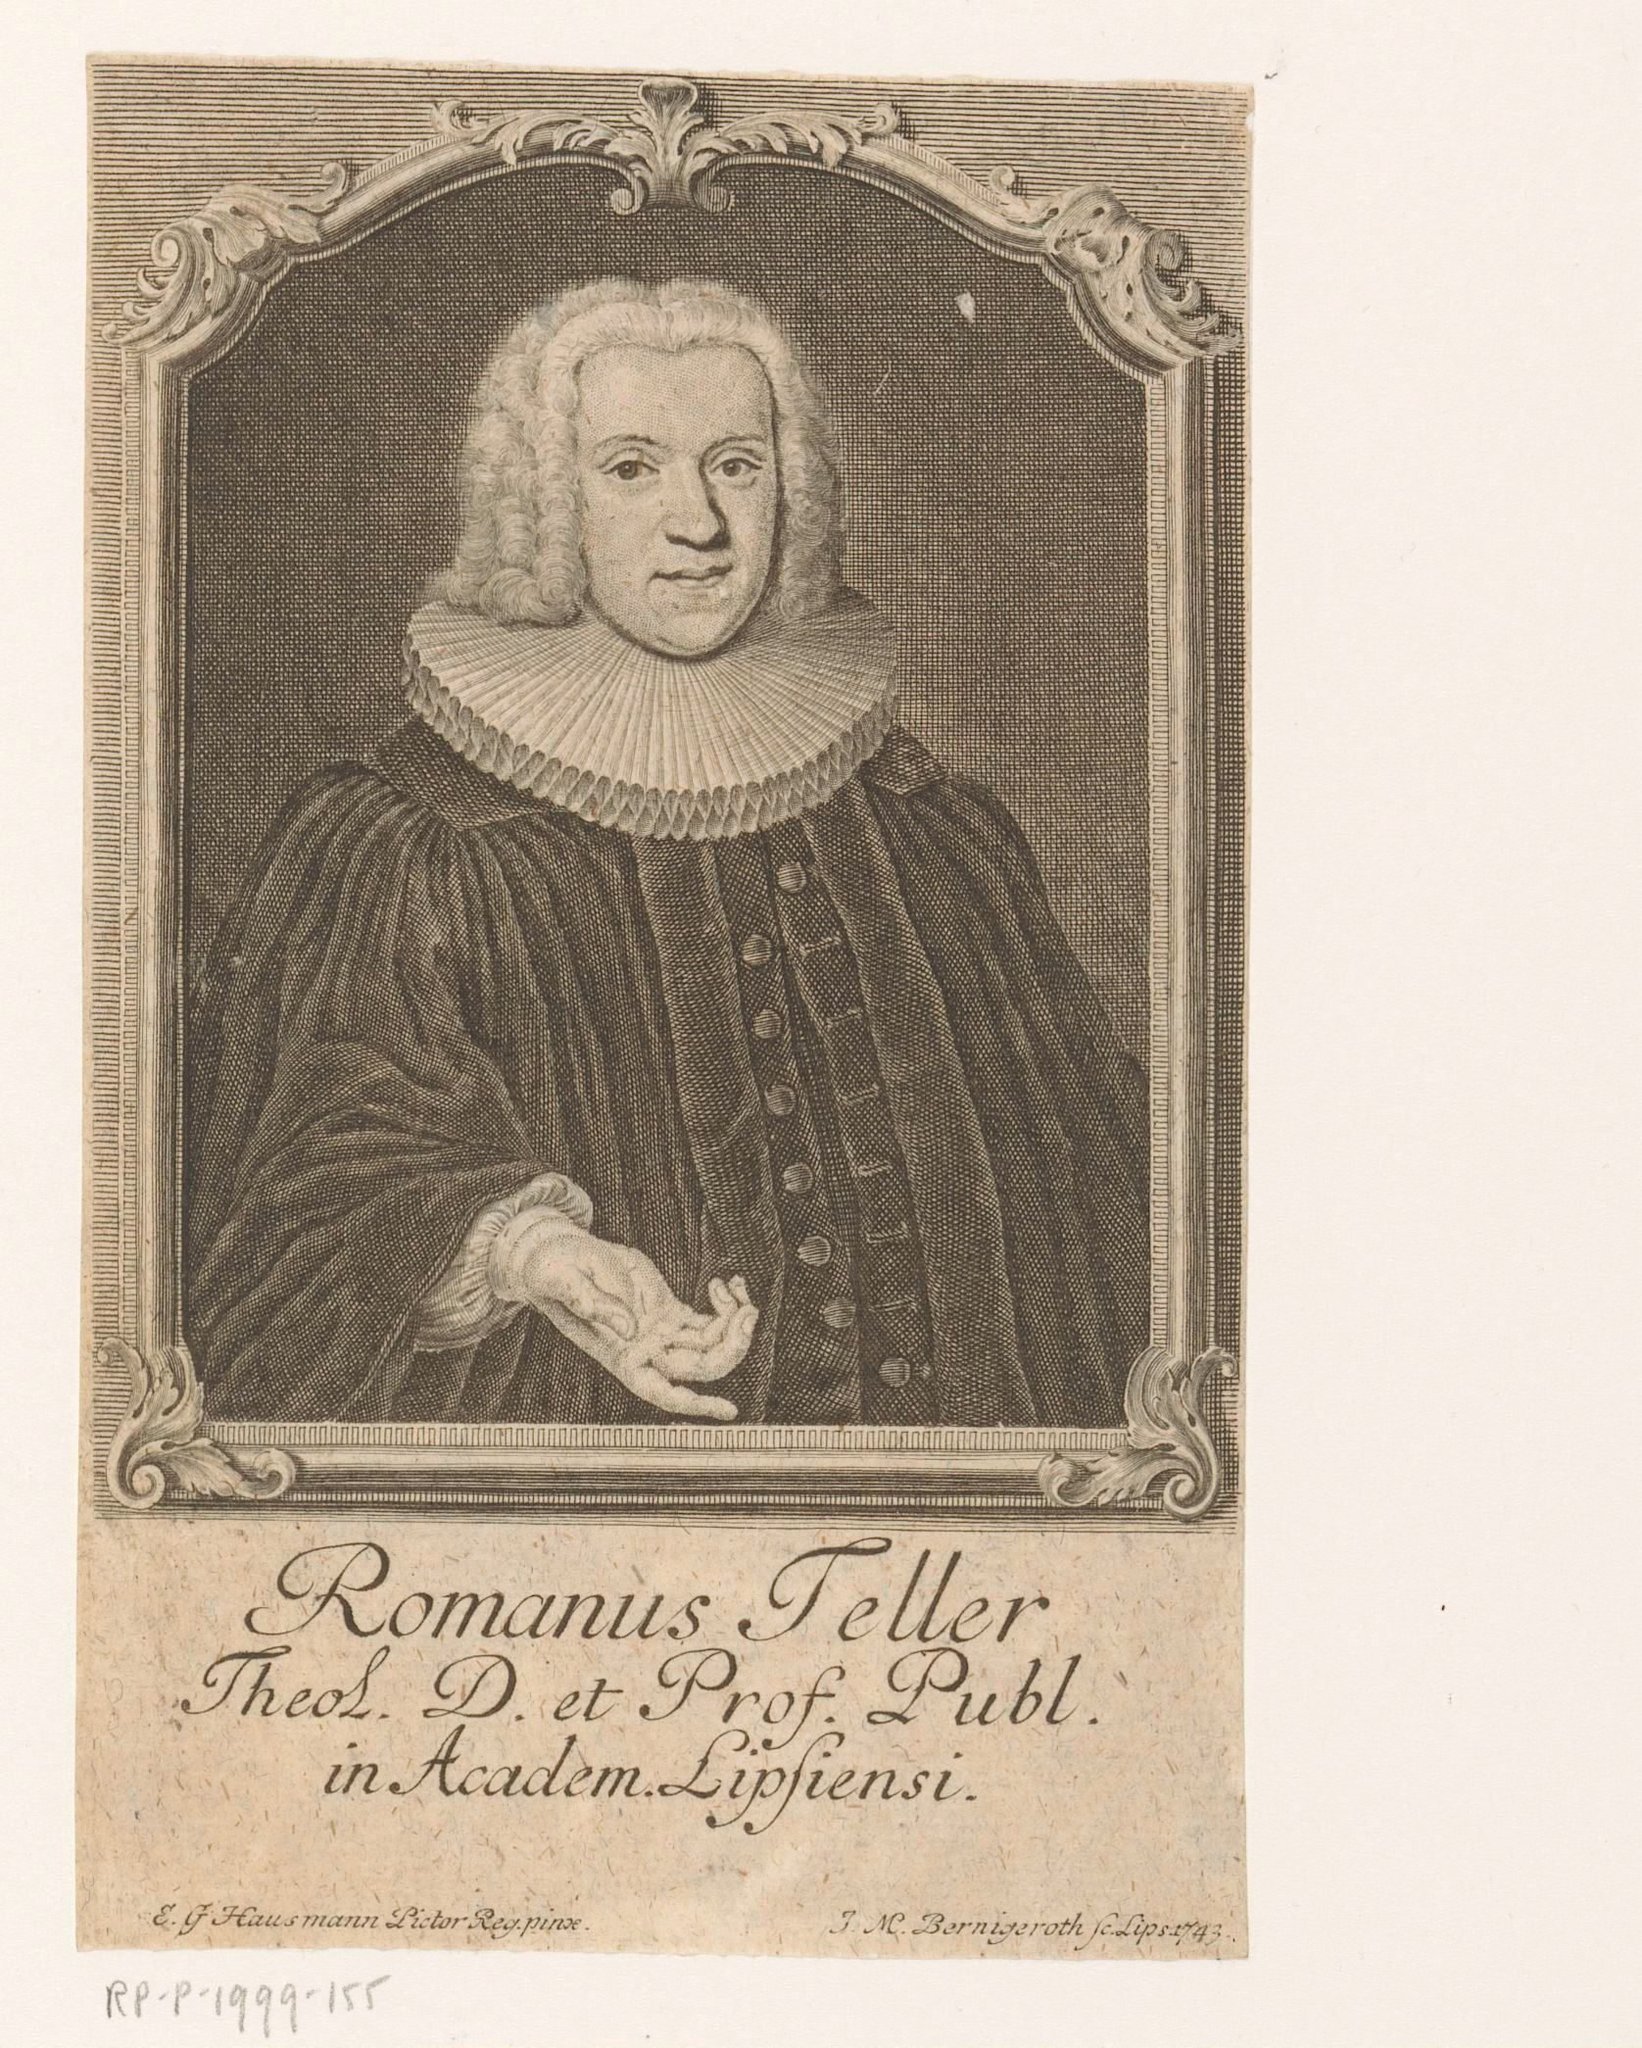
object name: print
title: Portret van Romanus III Teller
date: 1743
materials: paper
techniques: engraving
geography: leipzig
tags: historical persons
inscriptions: collector's mark: Lugt 2228, collector's mark: Lugt 2760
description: Prent ook gebruikt in: Zuverlässige Nachrichten von dem gegenwärtigen Zustande, Veränderung und Wachsthum der Wissenschaften. dl. 44. Leipzig: Johann Friedrich Gleditsch, 1743.